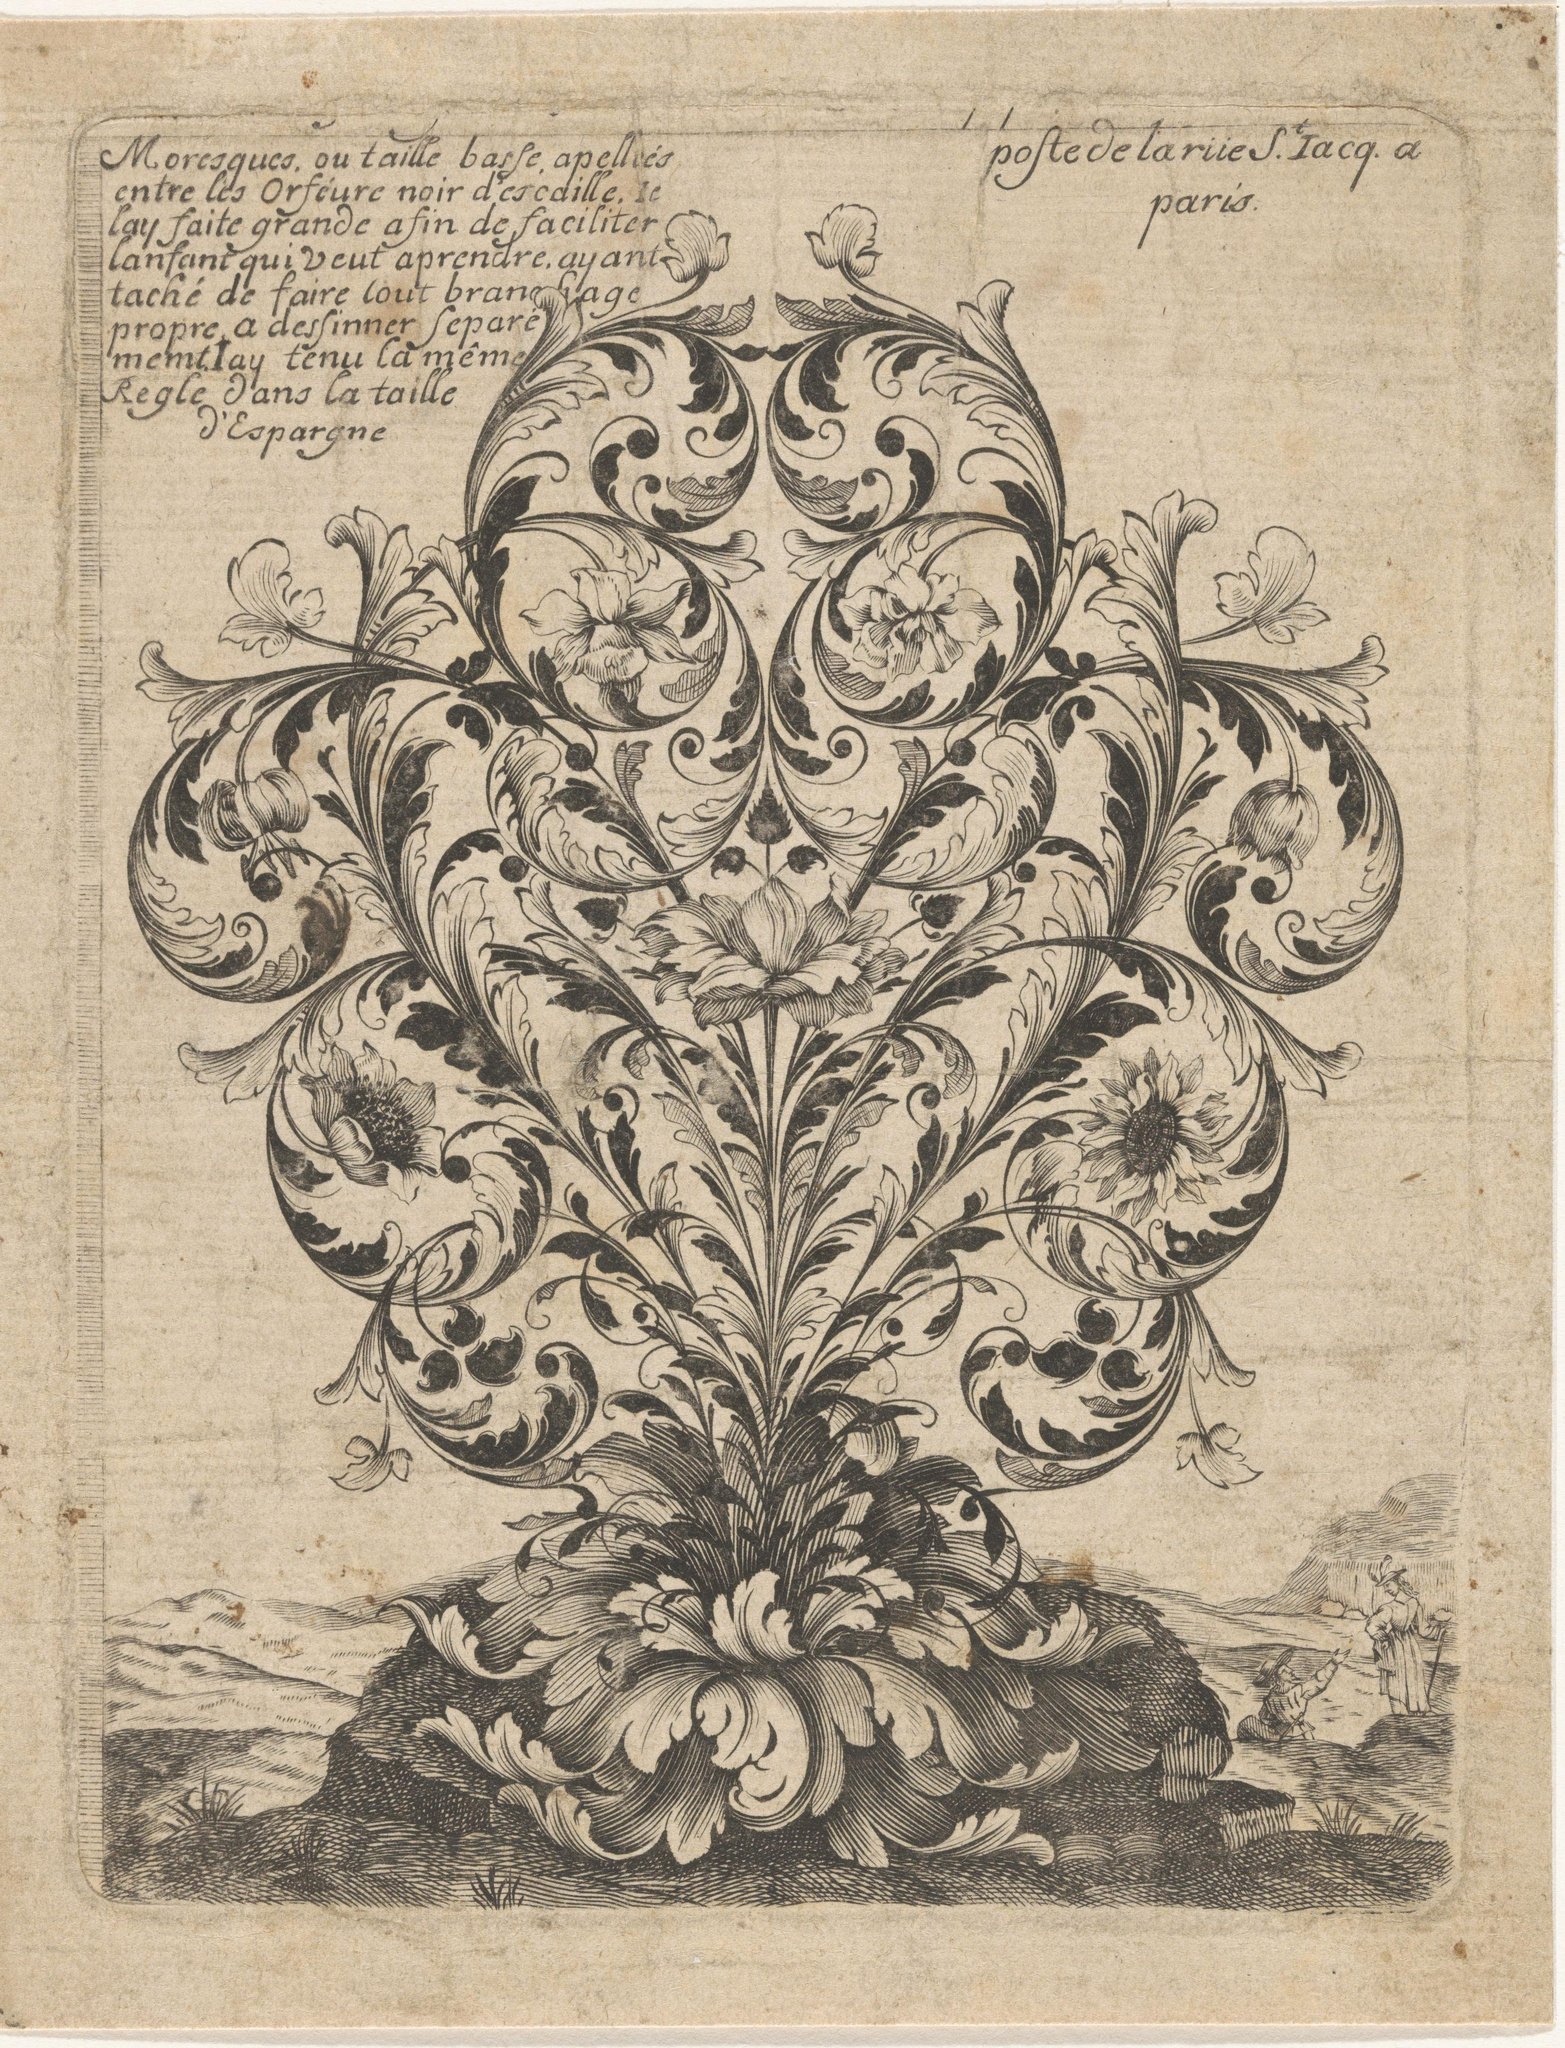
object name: ornament print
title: Edelsmidboeket met bladranken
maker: Anonymous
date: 1650-1670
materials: paper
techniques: engraving, etching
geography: paris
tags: rosette ~ ornament, ornaments ~ art, foliage ~ ornament, ornament ~ arabesque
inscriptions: collector's mark: Lugt 2760, address: ‘poste de la rue St. Iacq. a / Paris’, collector's mark: Lugt 2228, : ‘Moresques ... l'Espargne’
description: Niet aangetroffen in Gazette des Beaux-Arts. Deze prent is vermoedelijk een unieke afdruk die niet in de literatuur is beschreven. De prent is gemaakt door een niet geïdentificeerde edelsmid uit Parijs met als oogmerk kinderen een helder voorbeeld te geven van bladranken die deels in zwart zijn uitgevoerd (noir d’écaille = schildpadzwart).